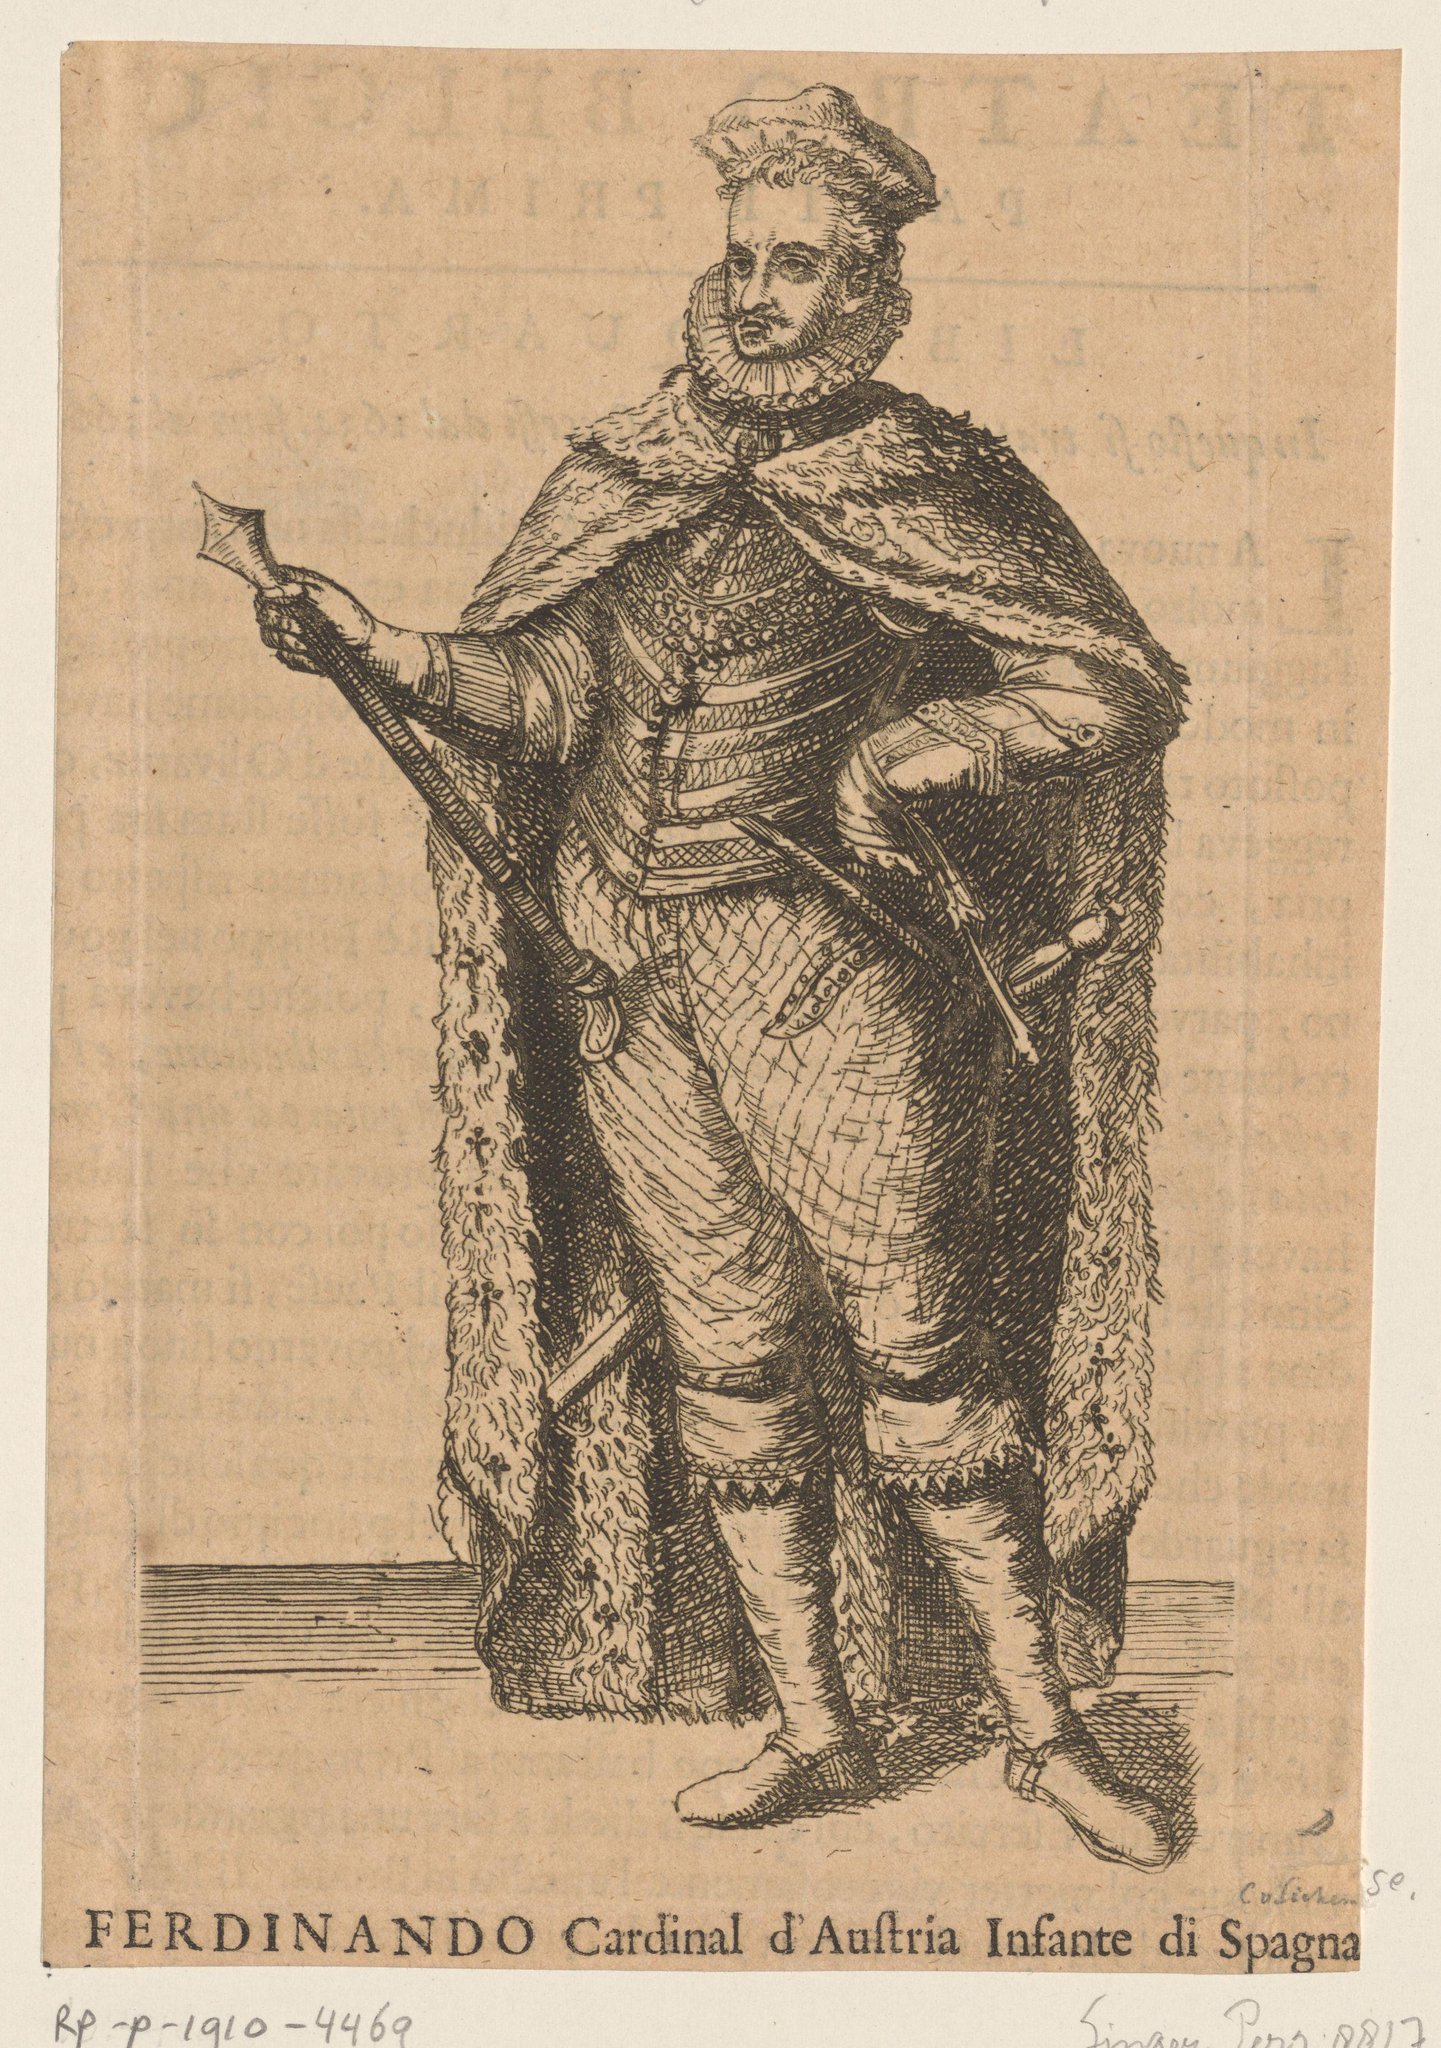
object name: book illustration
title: Portret van Ferdinand van Oostenrijk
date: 1690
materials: paper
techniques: etching, letterpress printing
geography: northern netherlands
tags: brussels, landvoogd der zuidelijke nederlanden ferdinand van oostenrijk, historical persons, coat, cape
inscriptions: collector's mark: Lugt 2228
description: Prent uit: Leti, Gregorio. Teatro Belgico, o verso ritratti historici, chronoligici, politici, e geografici (...). Amsterdam: Willem de Jonge, 1690, dl. 1.